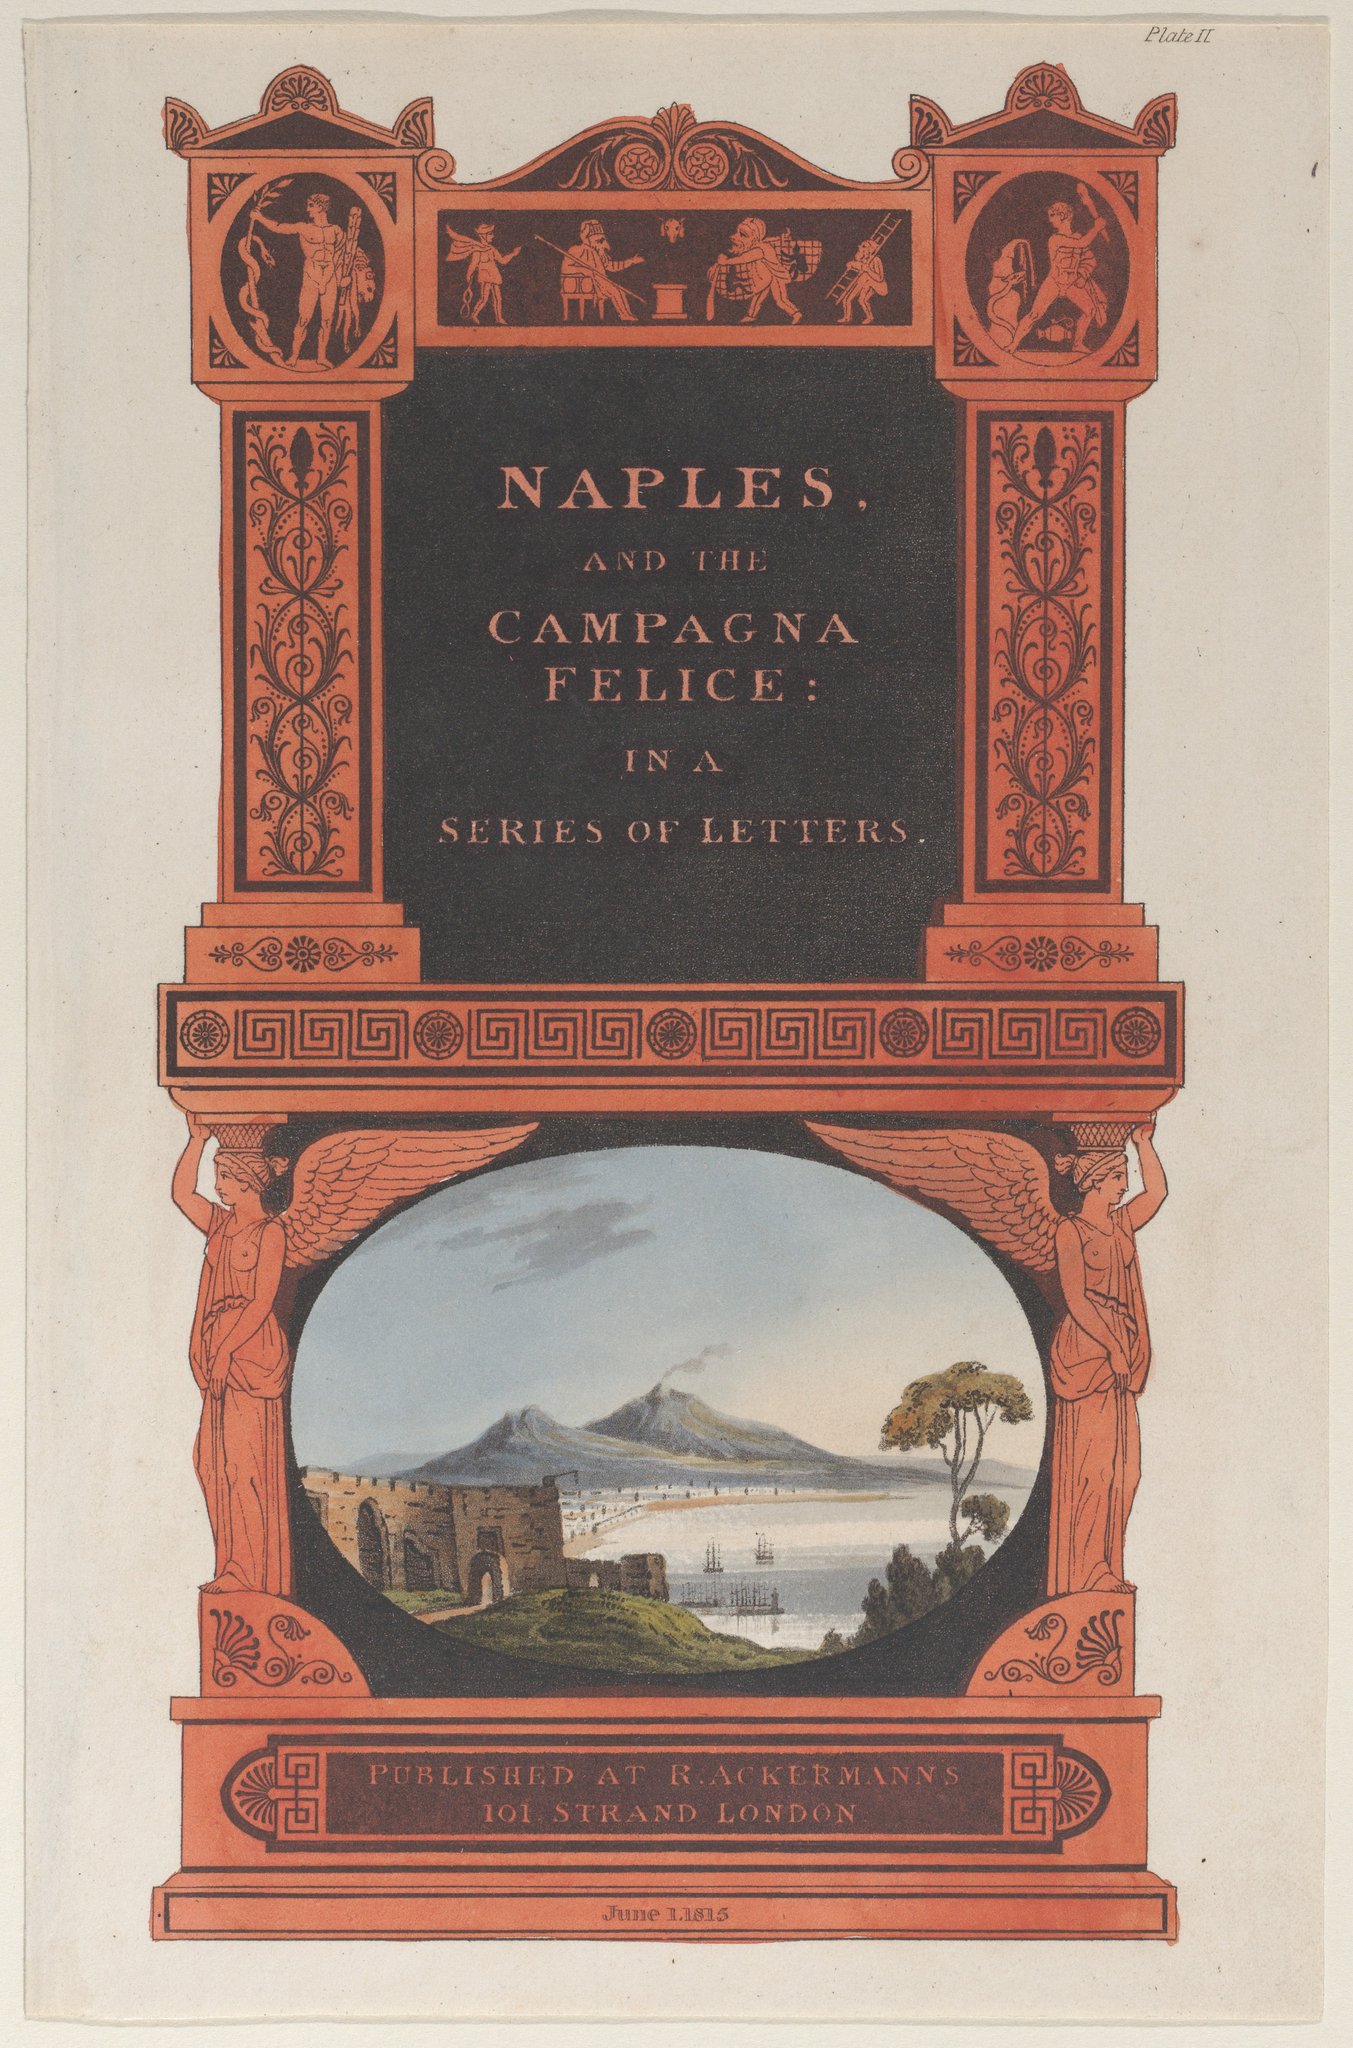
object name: print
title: Frontispiece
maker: thomas rowlandson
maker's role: artist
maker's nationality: british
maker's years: 1757-1827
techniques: aquatint, etching